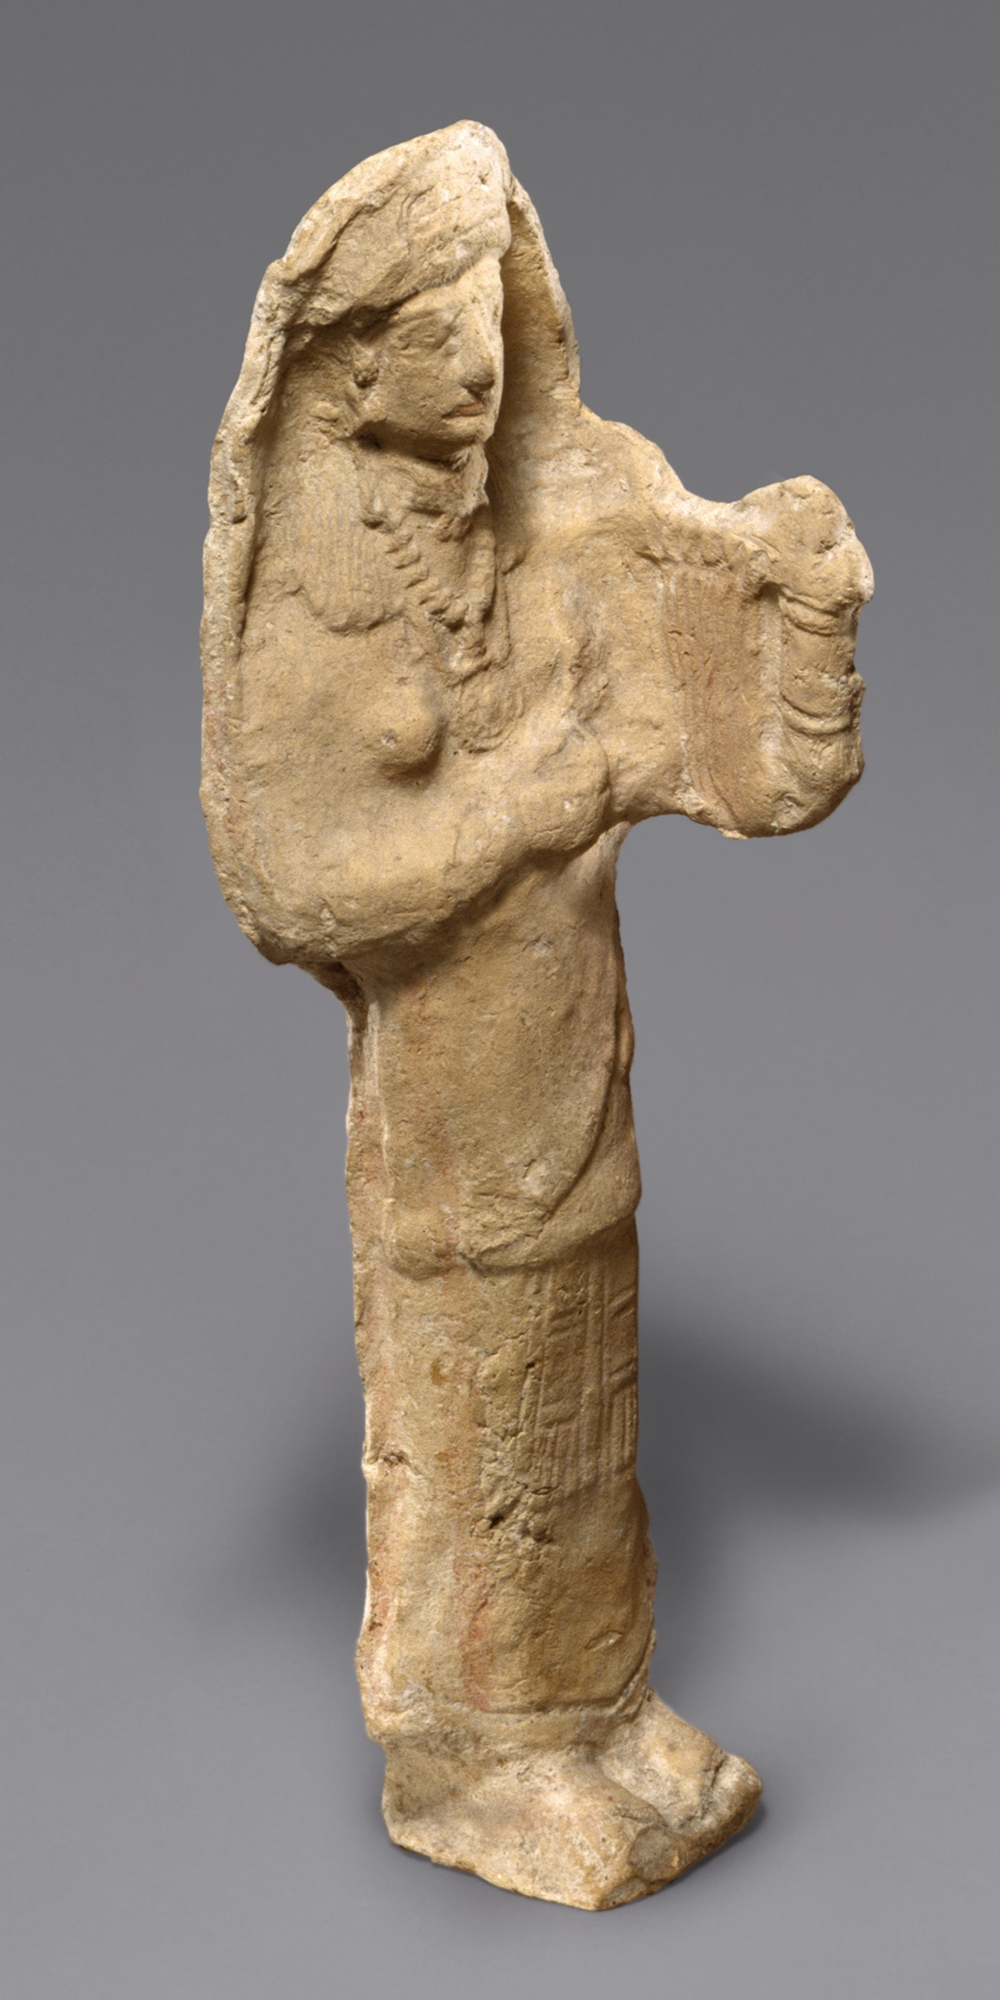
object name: statuette, woman, lyre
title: Terracotta musician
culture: cypriot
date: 600-480 BCE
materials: terracotta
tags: musical instruments,women,musicians